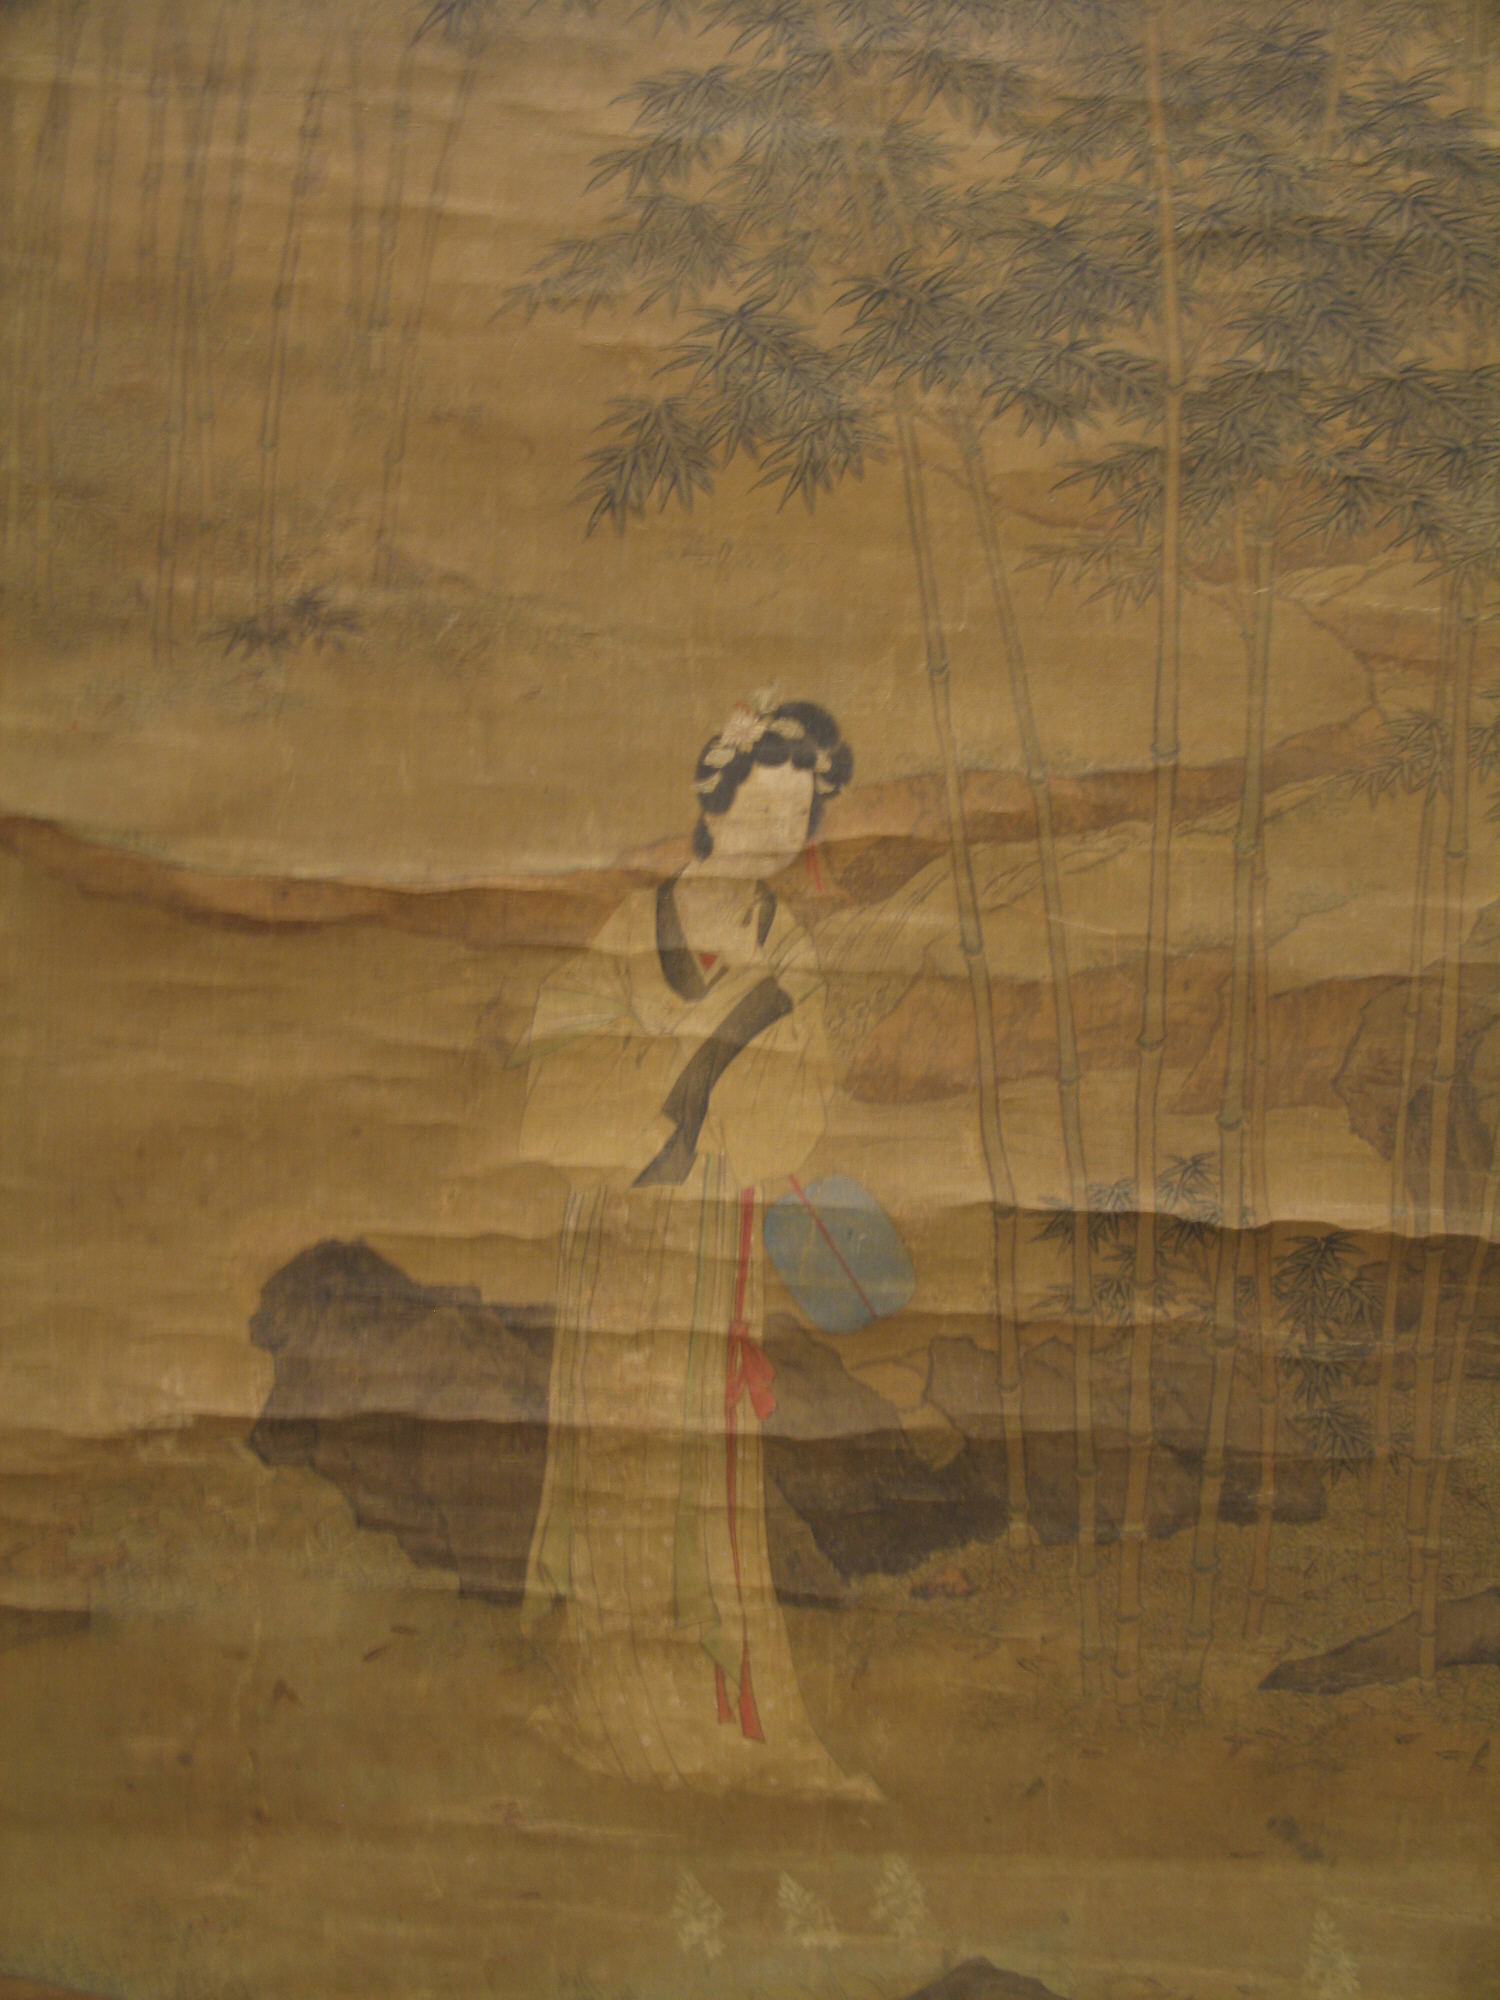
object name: hanging scroll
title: Lady in a Bamboo Grove after Qiu Ying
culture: chinese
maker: shen shuo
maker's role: artist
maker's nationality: chinese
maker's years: 1500-1600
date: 1544-1644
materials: ink, silk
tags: women,bamboo